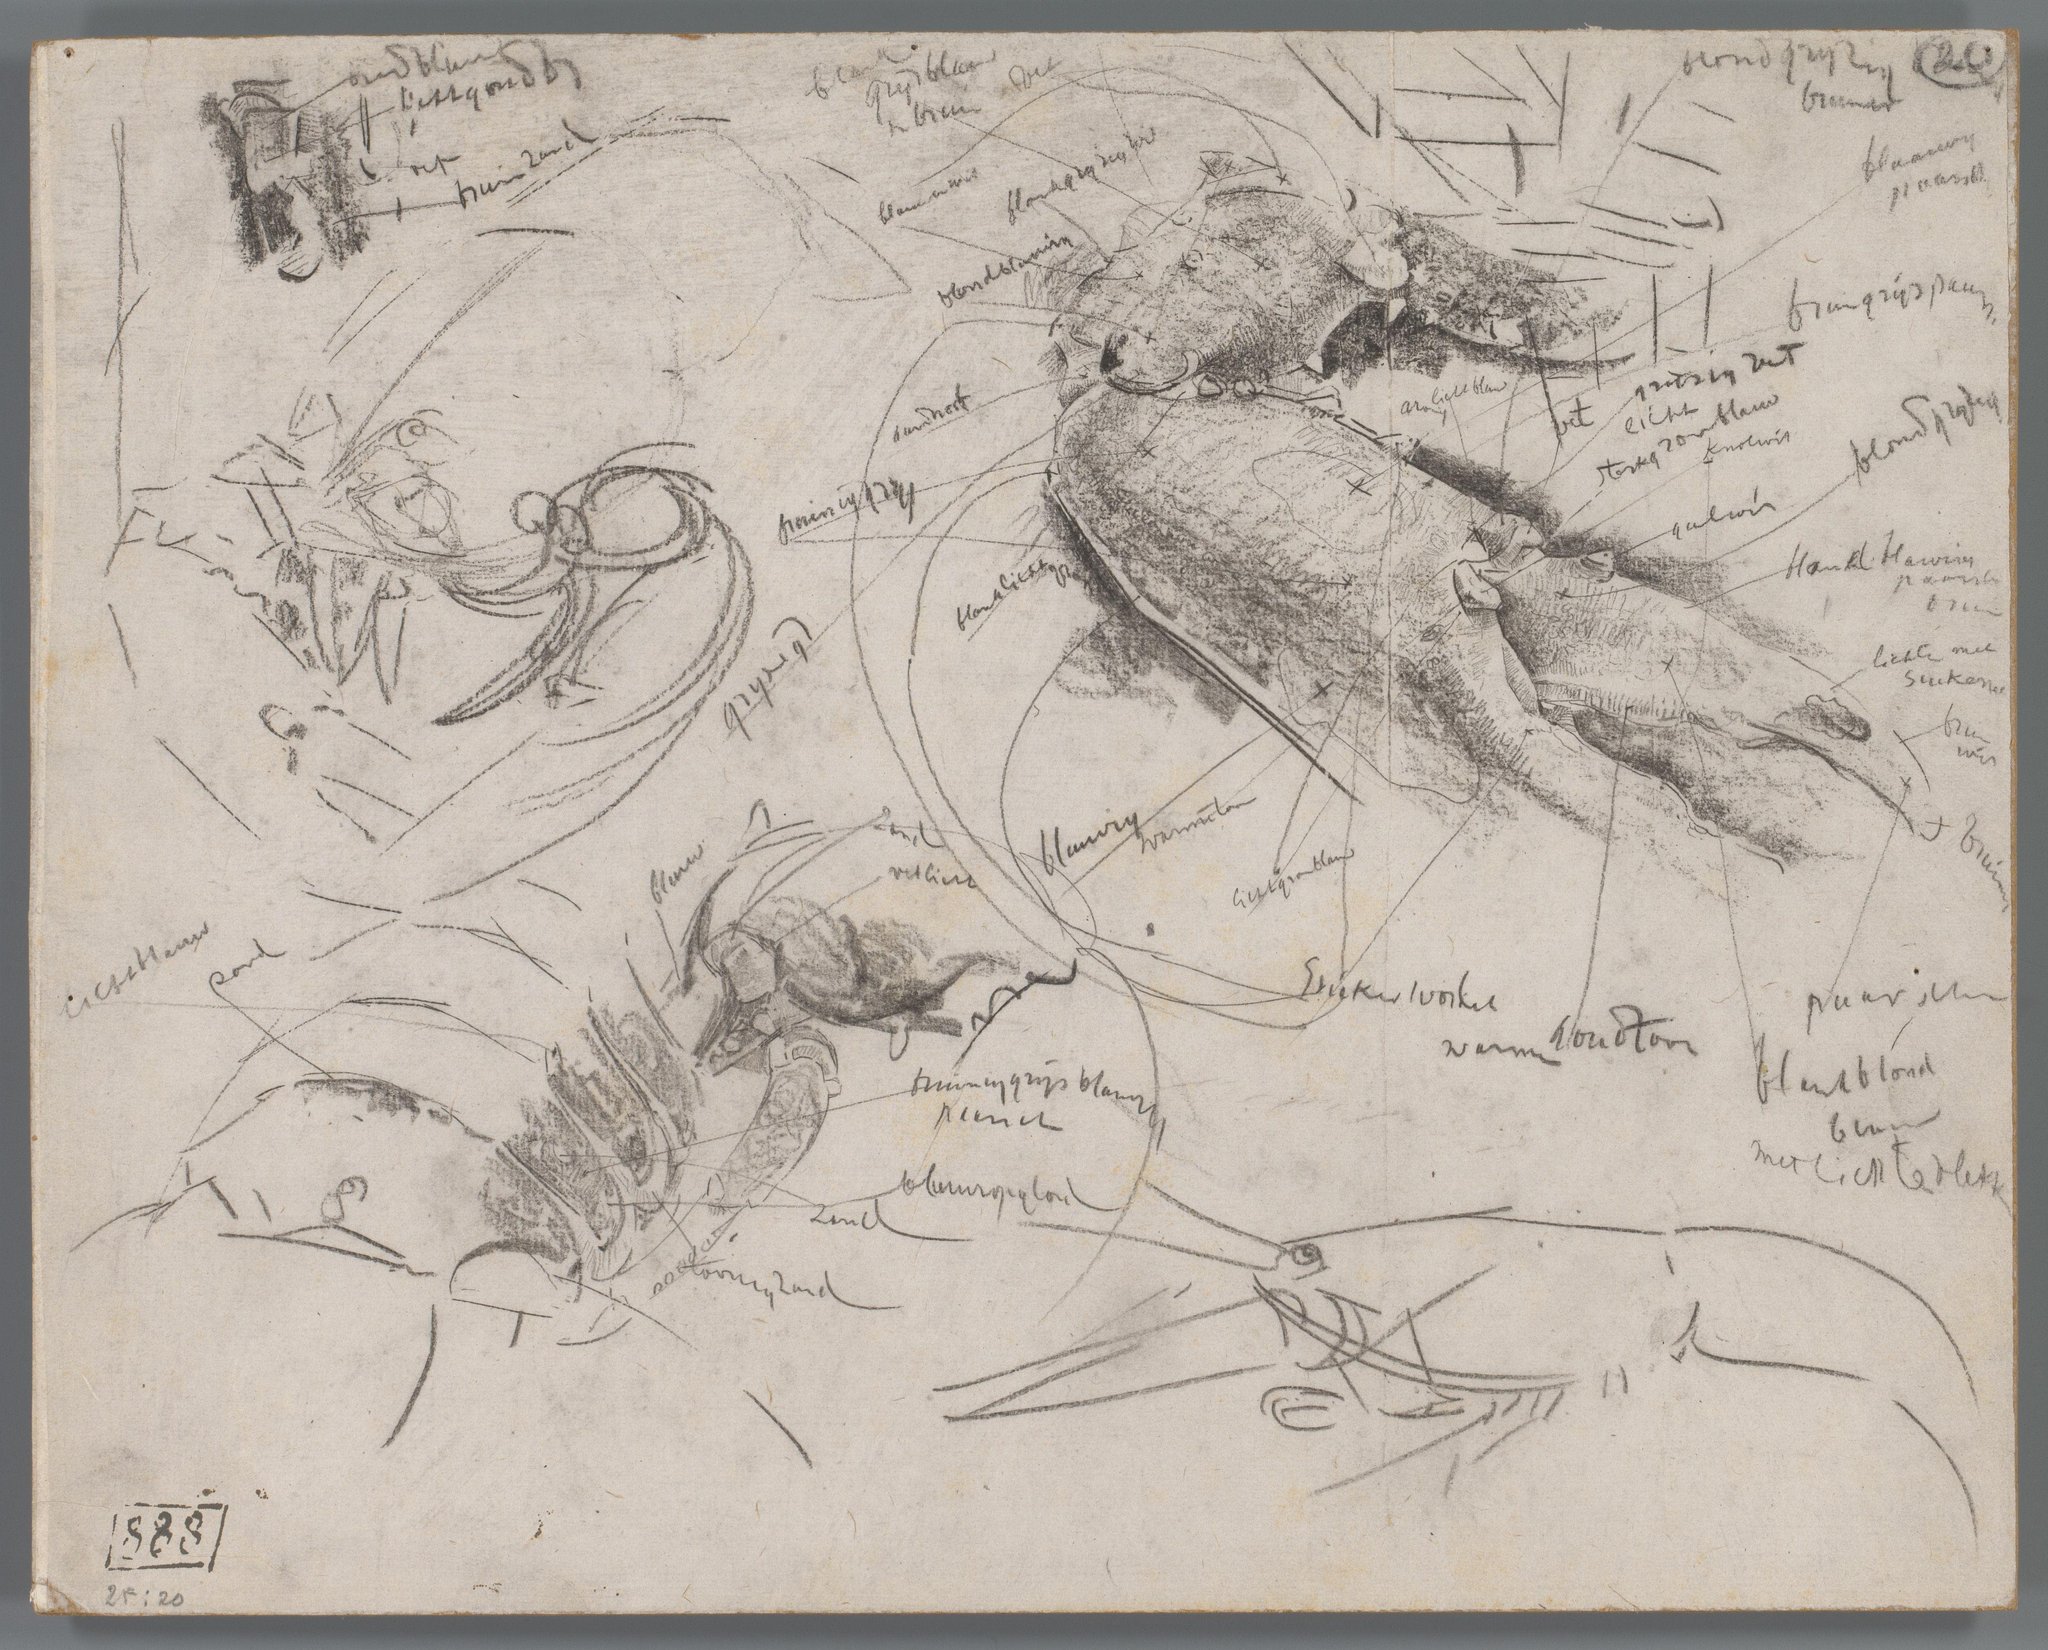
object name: drawing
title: Studies van kreeften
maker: gerrit willem dijsselhof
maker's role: designer, draughtsman, print maker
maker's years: 1866-1924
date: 1876-1924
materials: cardboard, chalk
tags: crustaceans: lobster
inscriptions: number: ‘20’, number: ‘888’